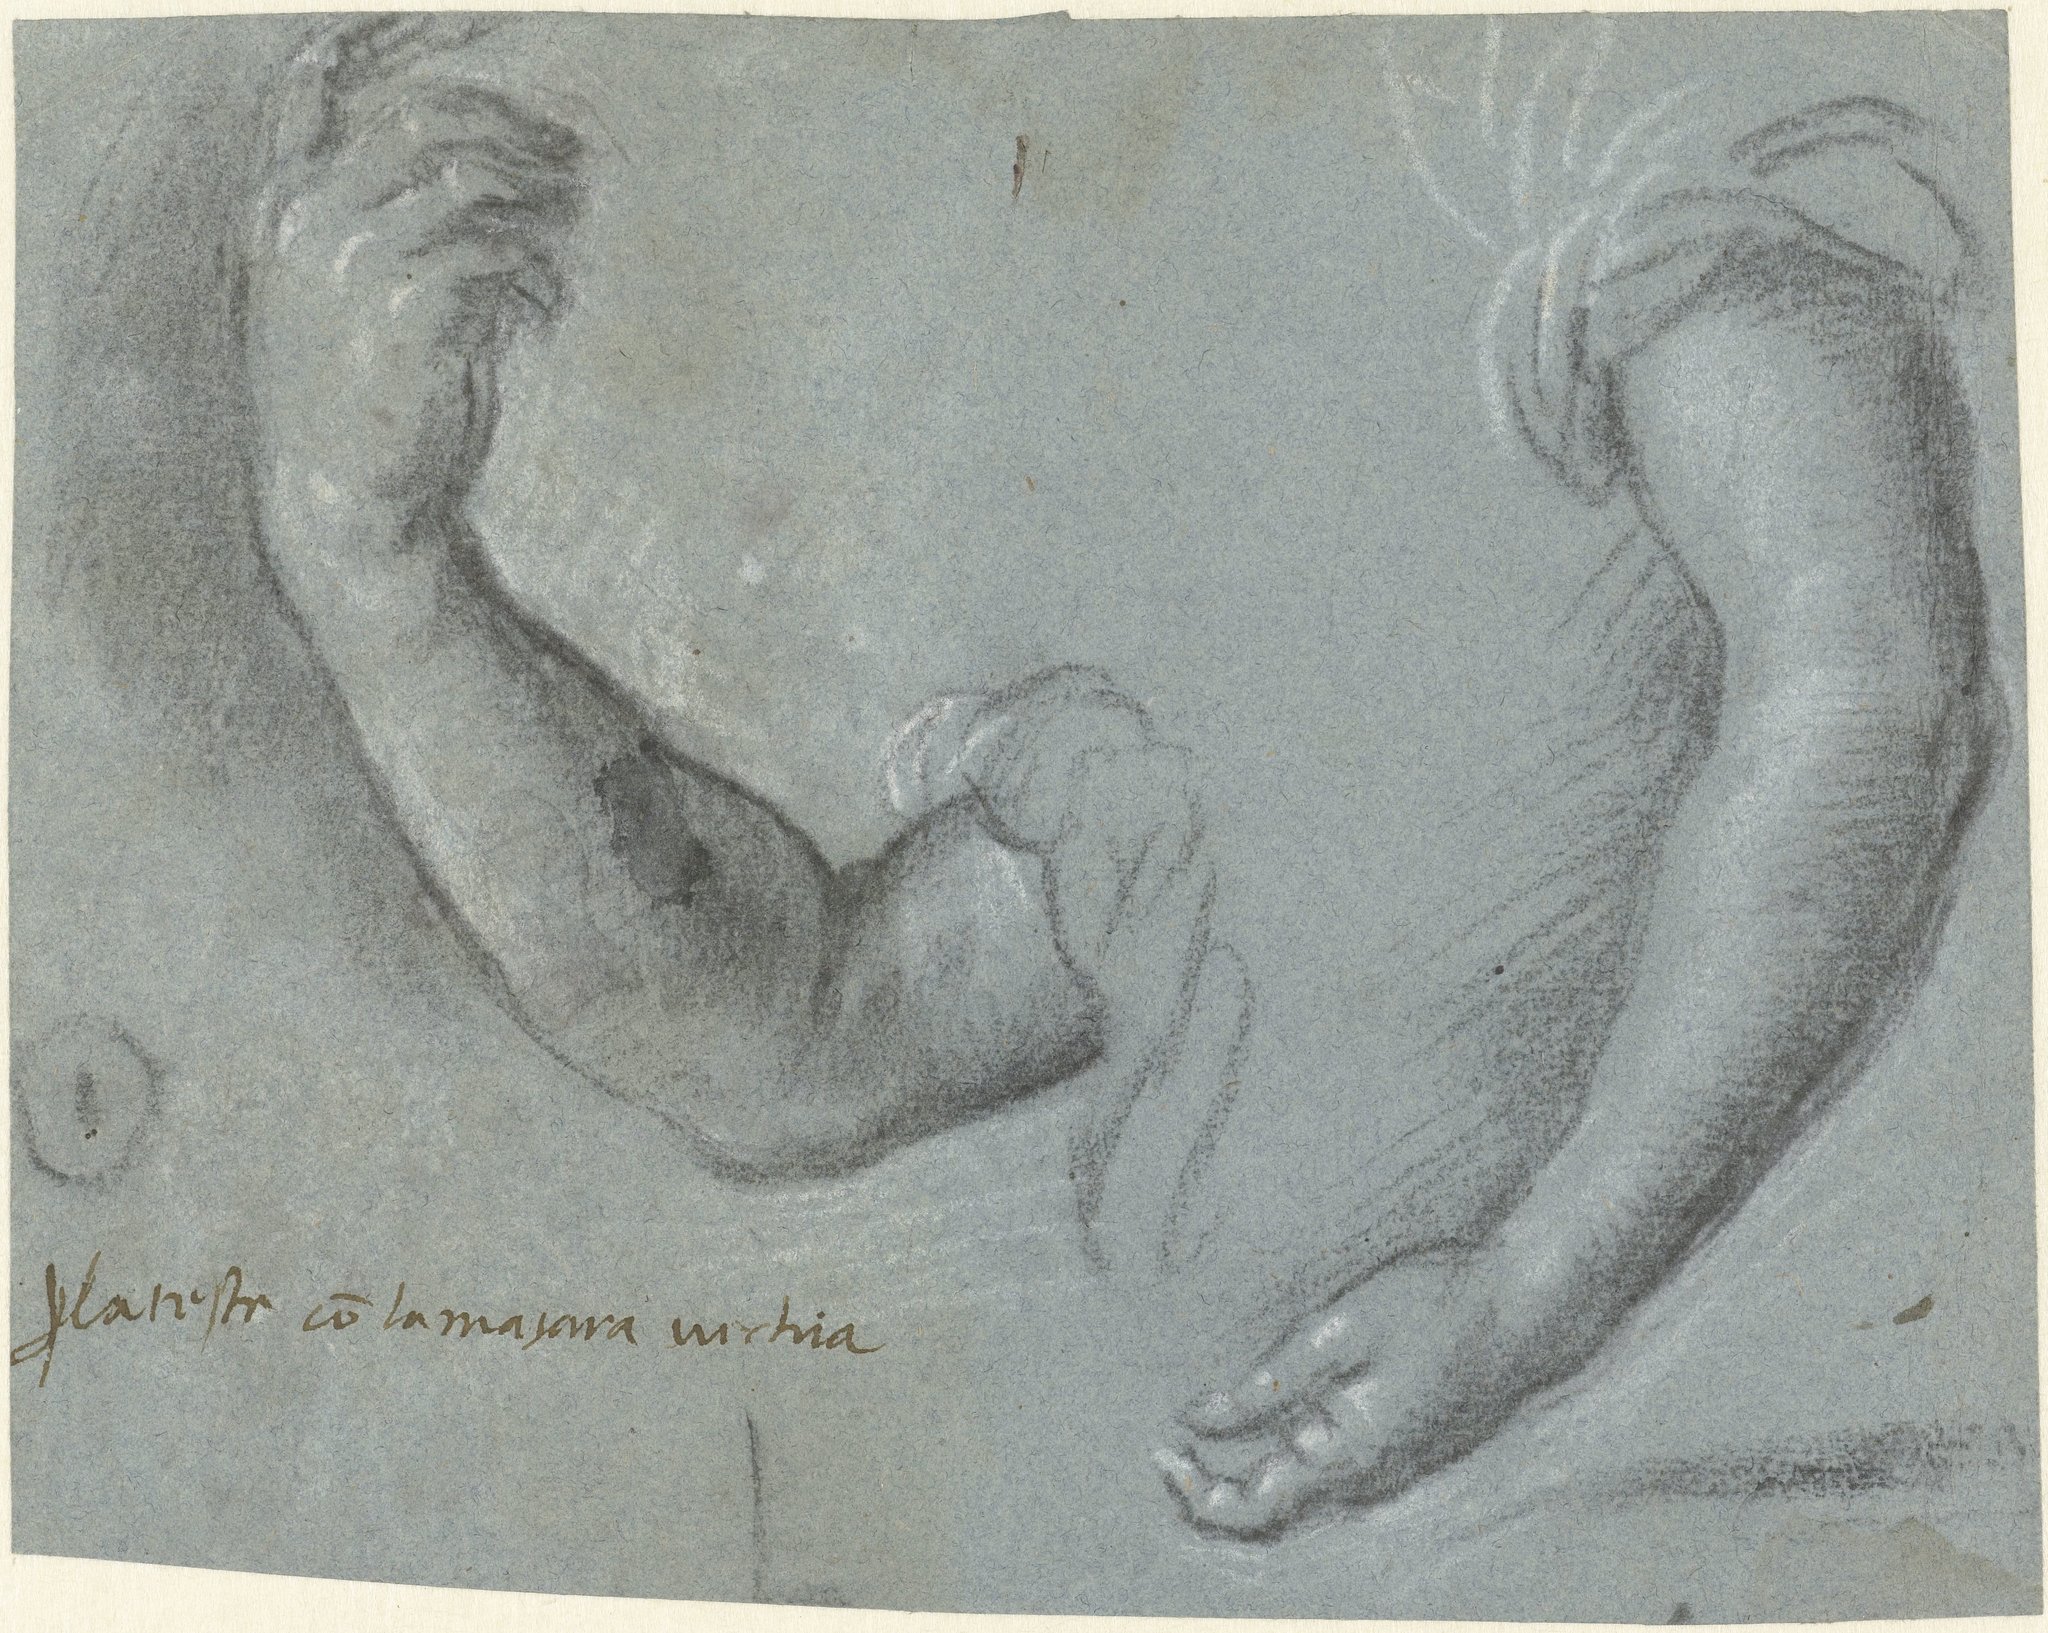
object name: drawing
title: Twee armen van een vrouw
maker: paris bordone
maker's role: draughtsman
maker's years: 1500-1571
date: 1510-1571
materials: chalk, paper